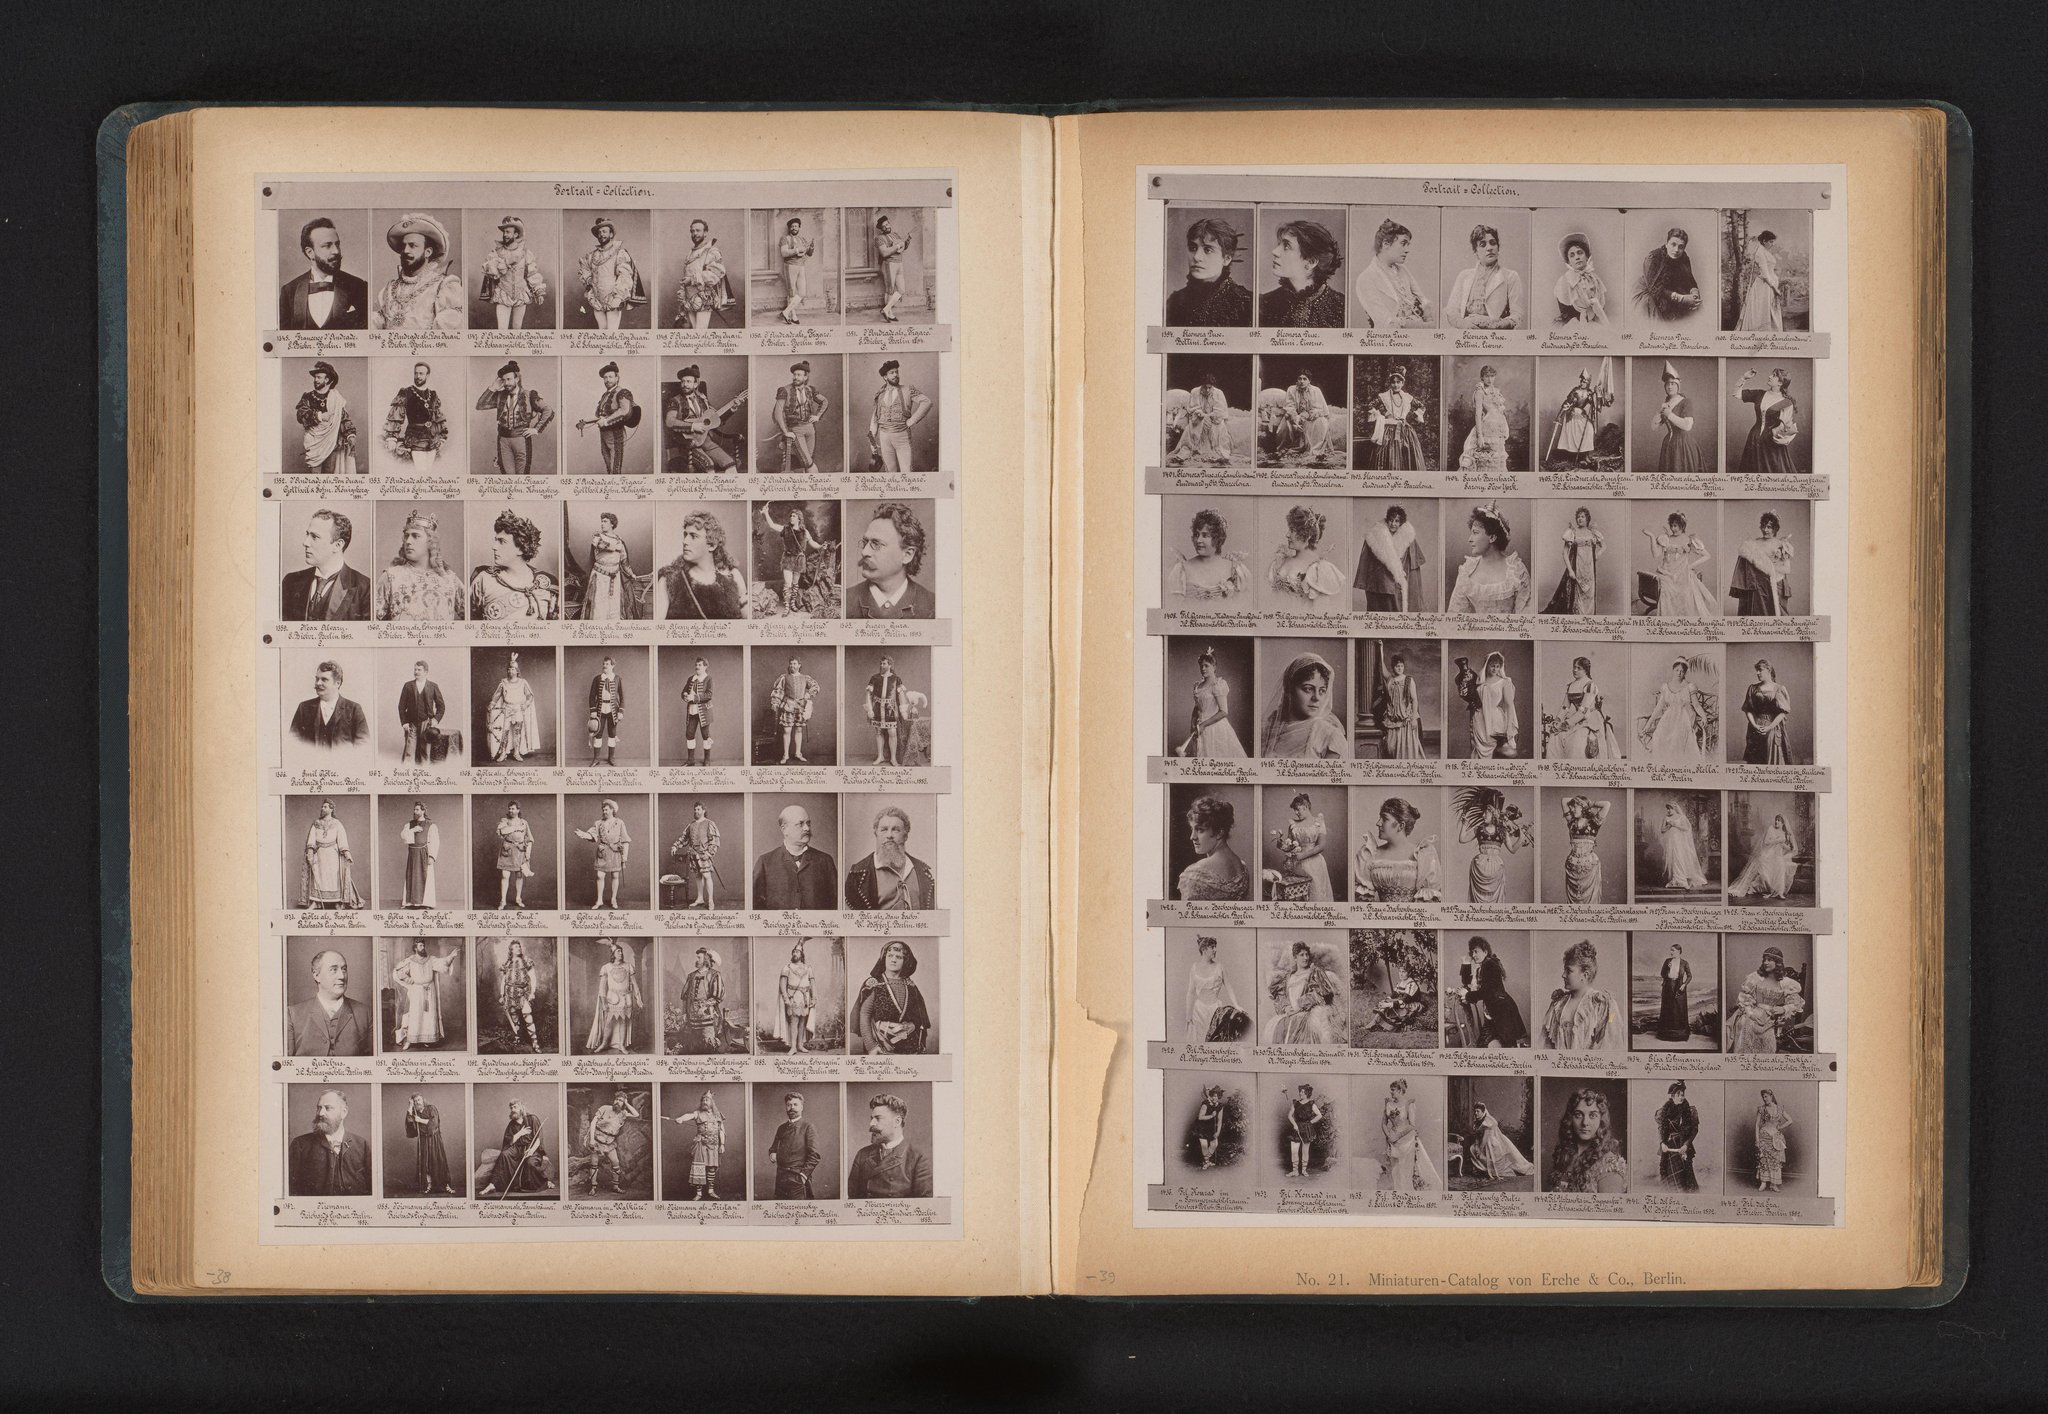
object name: photomechanical print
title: Portretten van Duitse acteurs en actrices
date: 1880-1885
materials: paper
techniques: photograph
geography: berlin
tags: portrait of actor, actress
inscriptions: number: ‘No. 21.’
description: Prent op negenendertigste ongenummerde pagina.